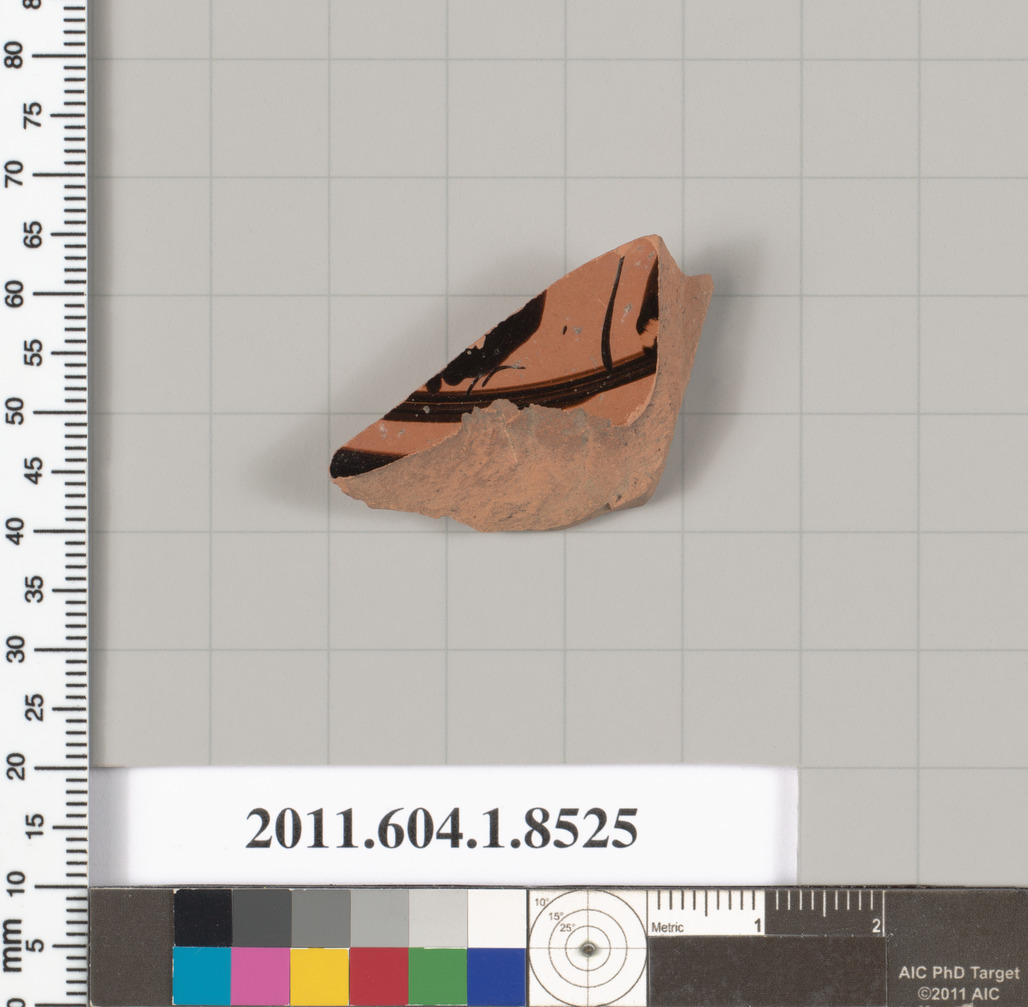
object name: kylix fragment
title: Terracotta fragment of a stemless kylix (drinking cup)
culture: greek, attic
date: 467-435 BCE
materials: terracotta